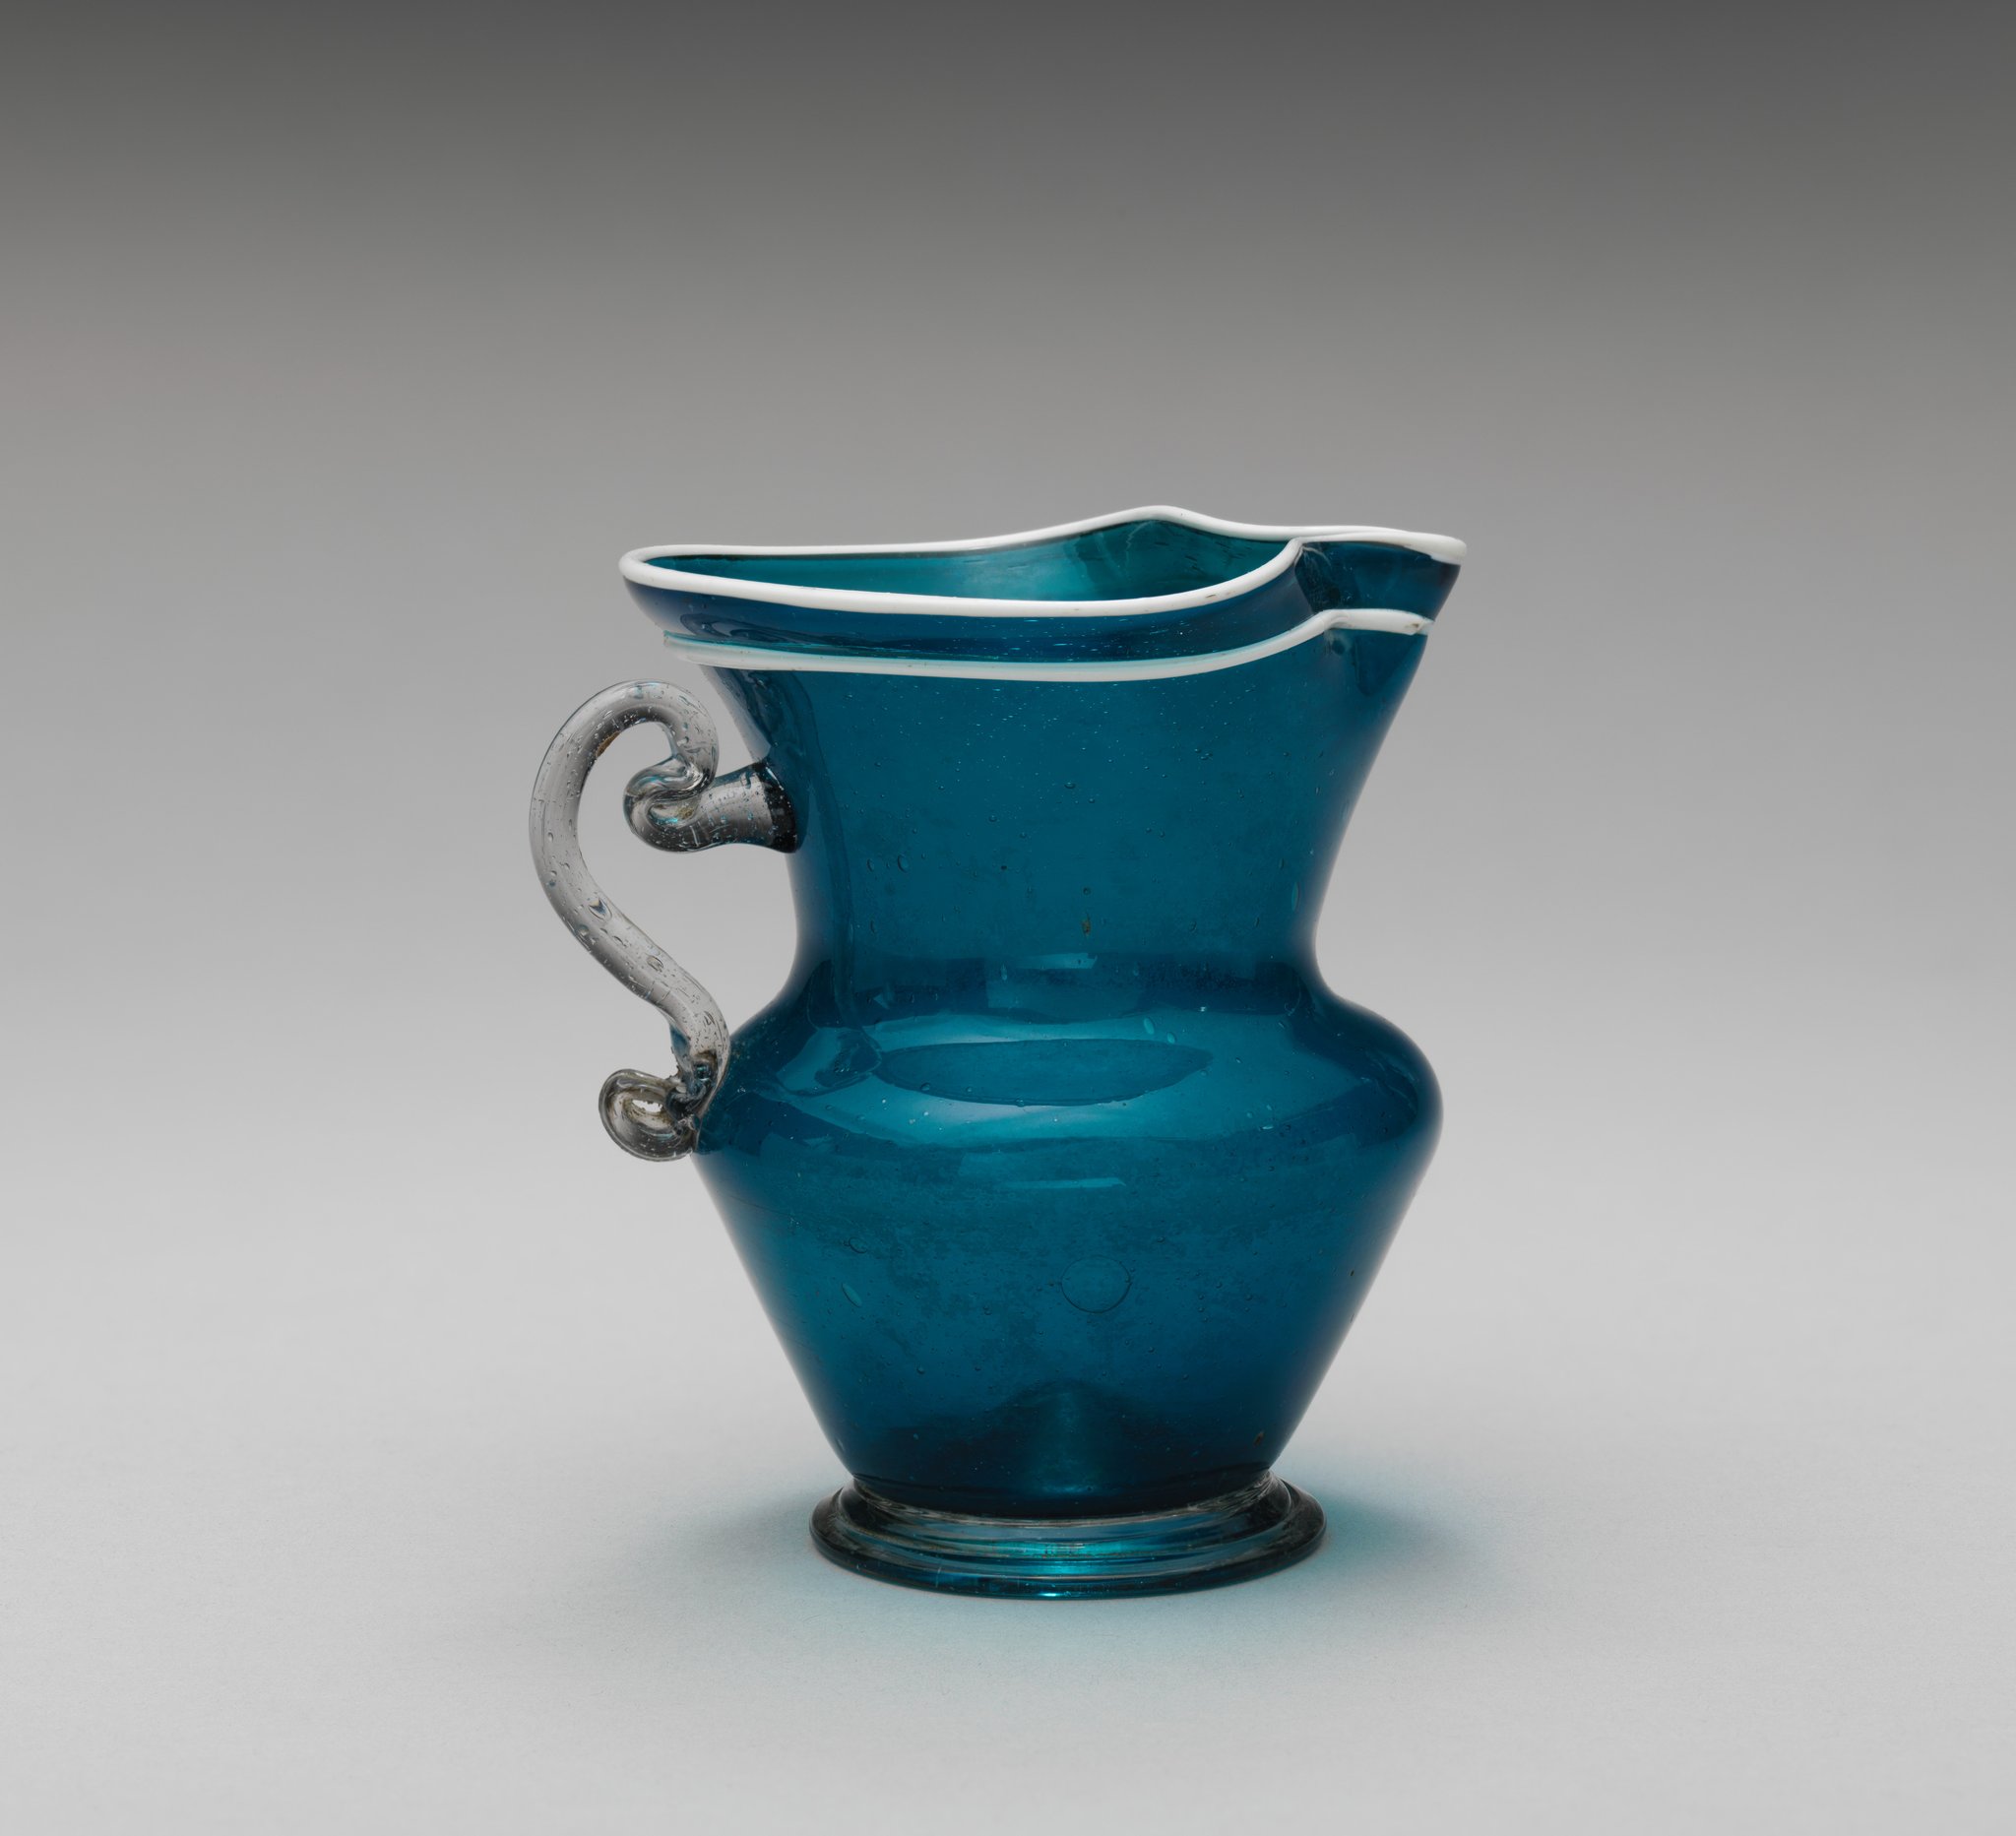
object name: jug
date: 1701-1800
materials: glass